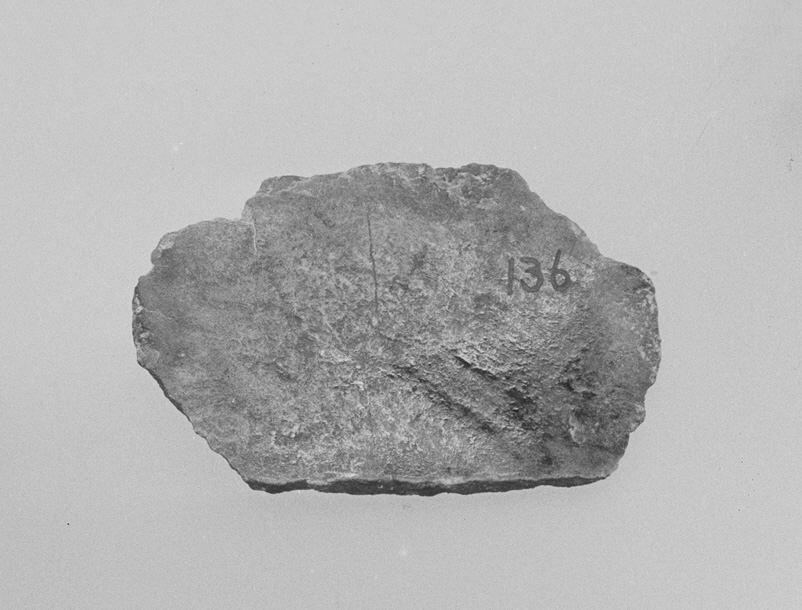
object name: fragment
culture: german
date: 1902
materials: jade